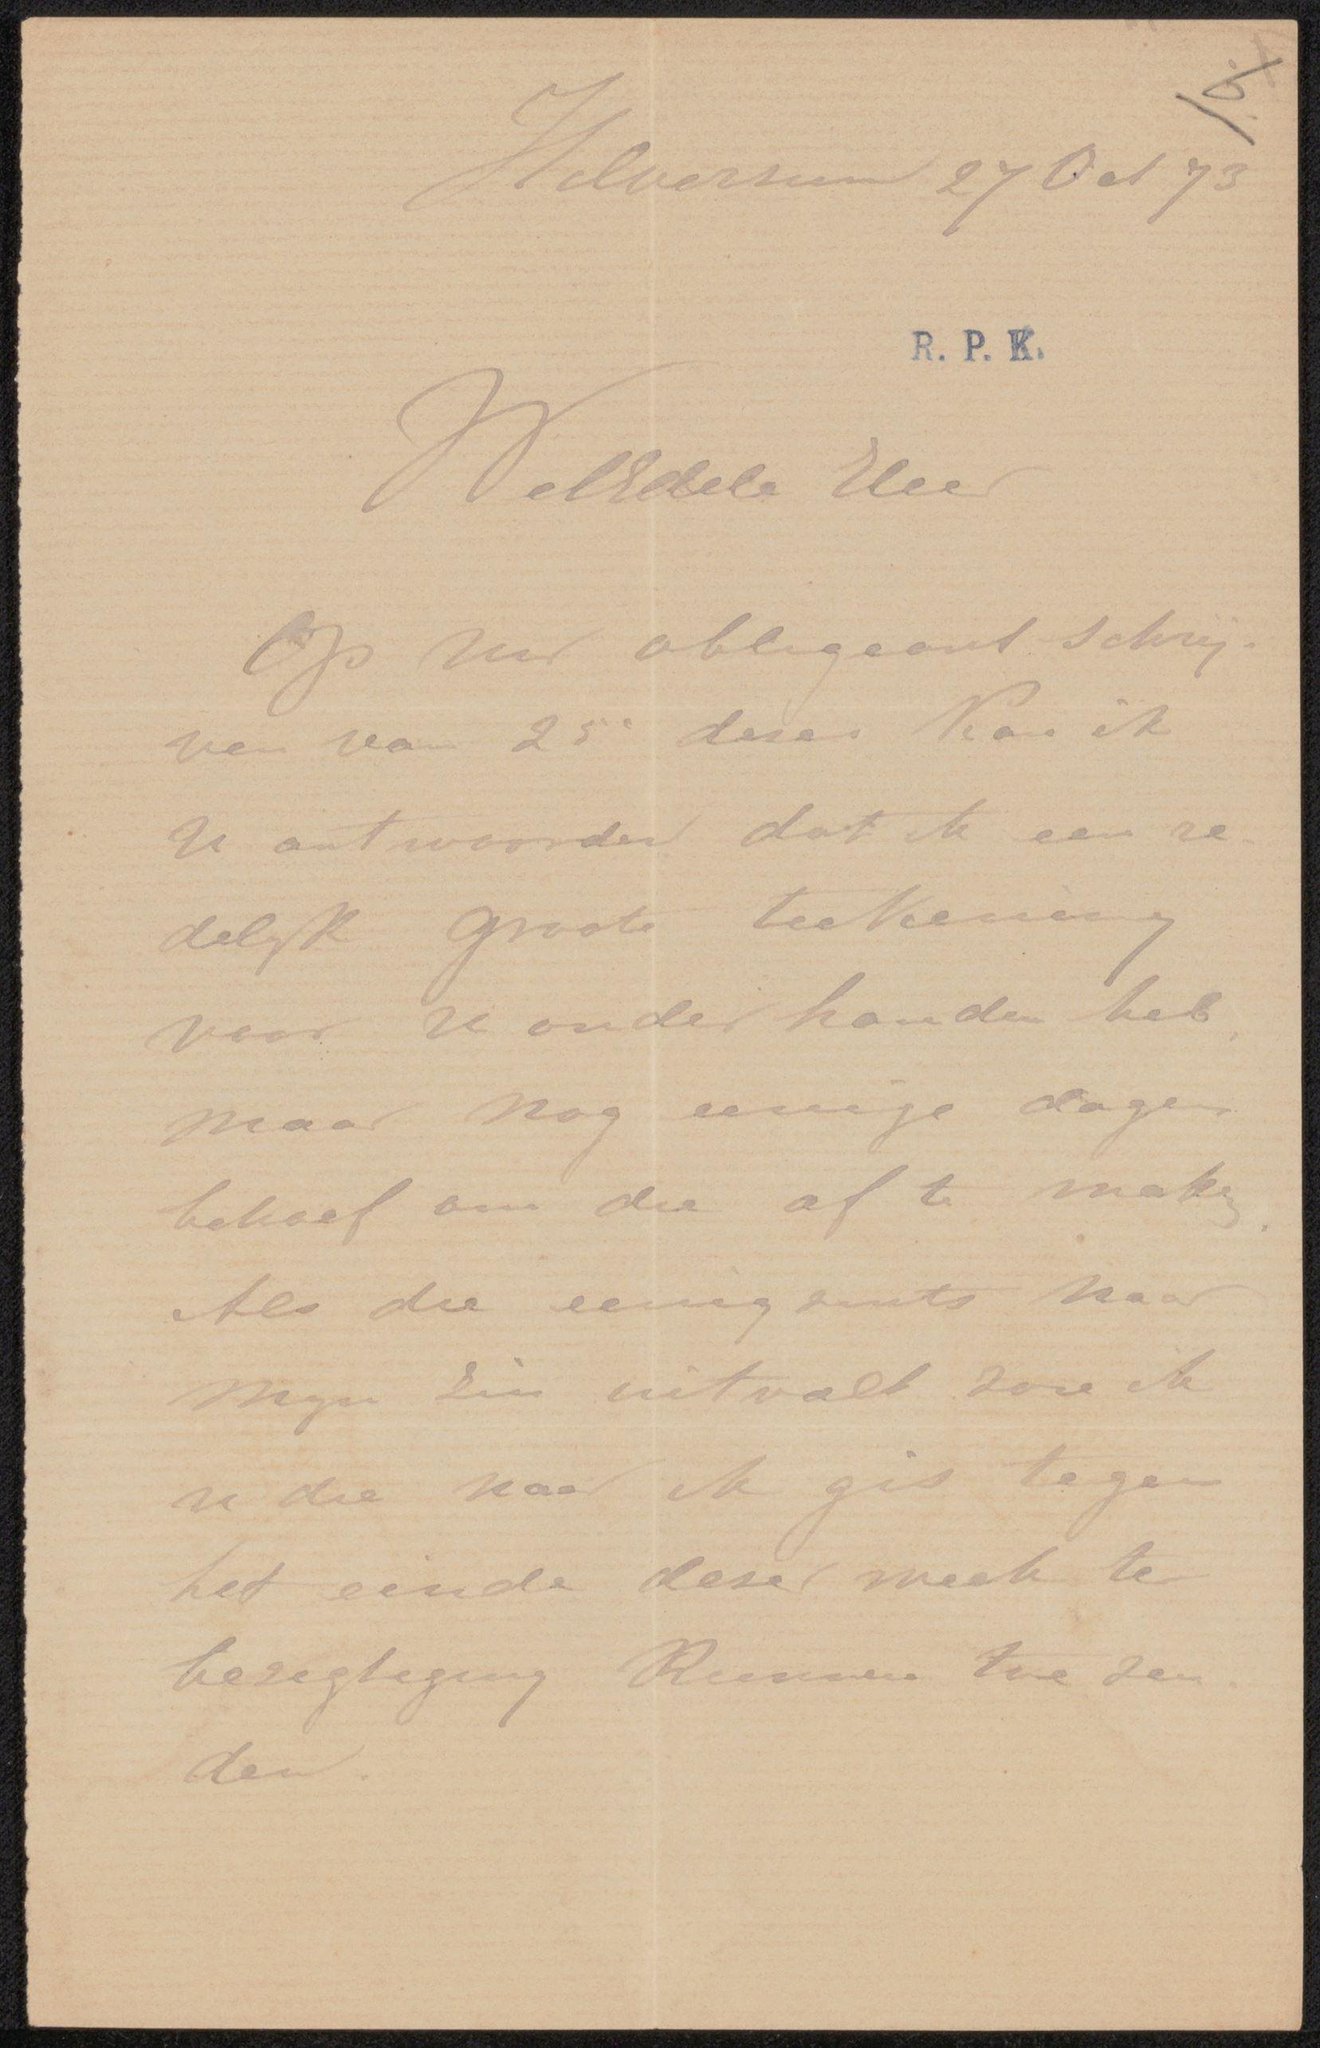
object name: letter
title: Brief aan Frans Buffa en Zonen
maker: hendrik albert van trigt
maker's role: draughtsman, painter, print maker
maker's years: 1829-1899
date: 1873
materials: ink, paper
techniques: pen, writing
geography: hilversum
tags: publisher, drawing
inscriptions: collector's mark: Lugt 2233